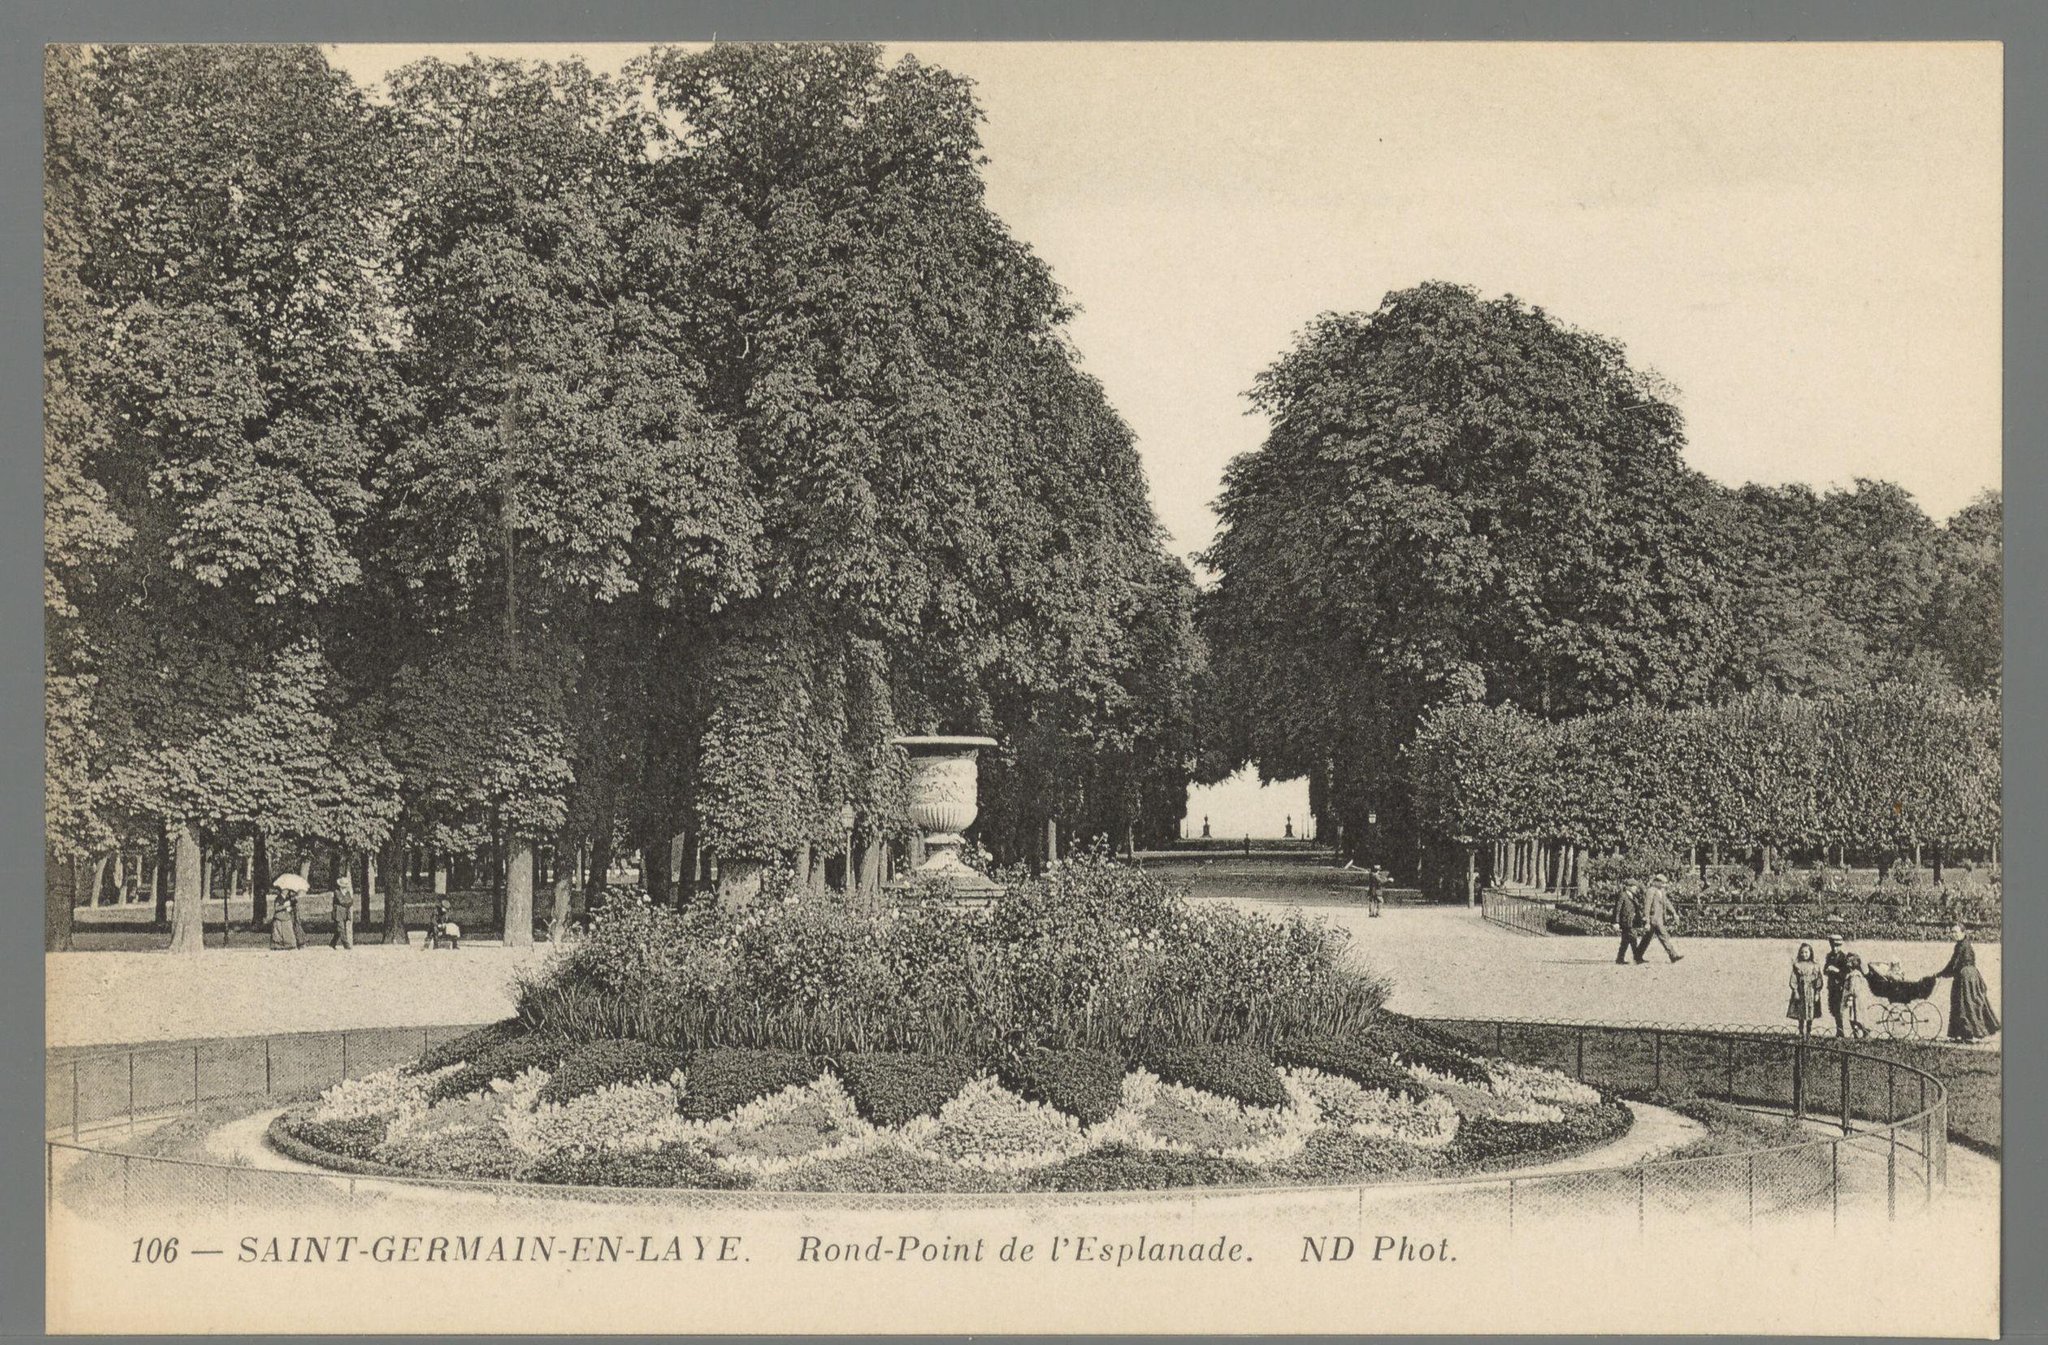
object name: ansichtkaart, prentbriefkaart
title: Saint-Germain-en-Laye. Rond-Point de l'Esplanade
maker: Anonymous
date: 1903-1918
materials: cardboard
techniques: photograph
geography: paris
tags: public gardens, park (+ city(-scape) with figures, staffage), statues, sculptures in garden